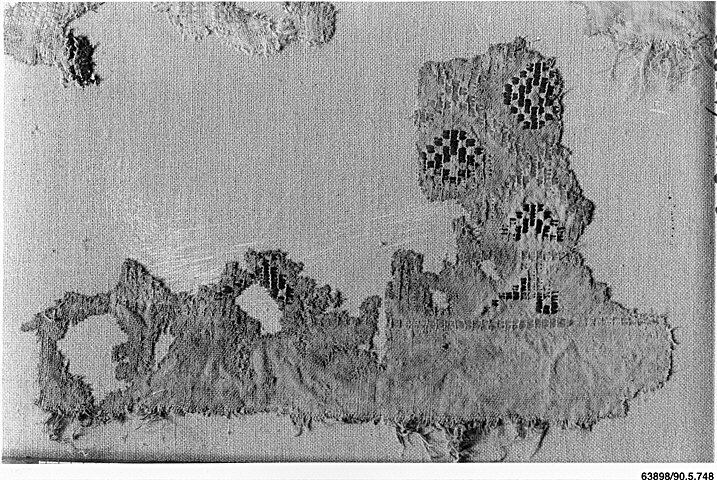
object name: textile fragment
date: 401-600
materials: linen, wool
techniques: brocade, weave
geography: egypt